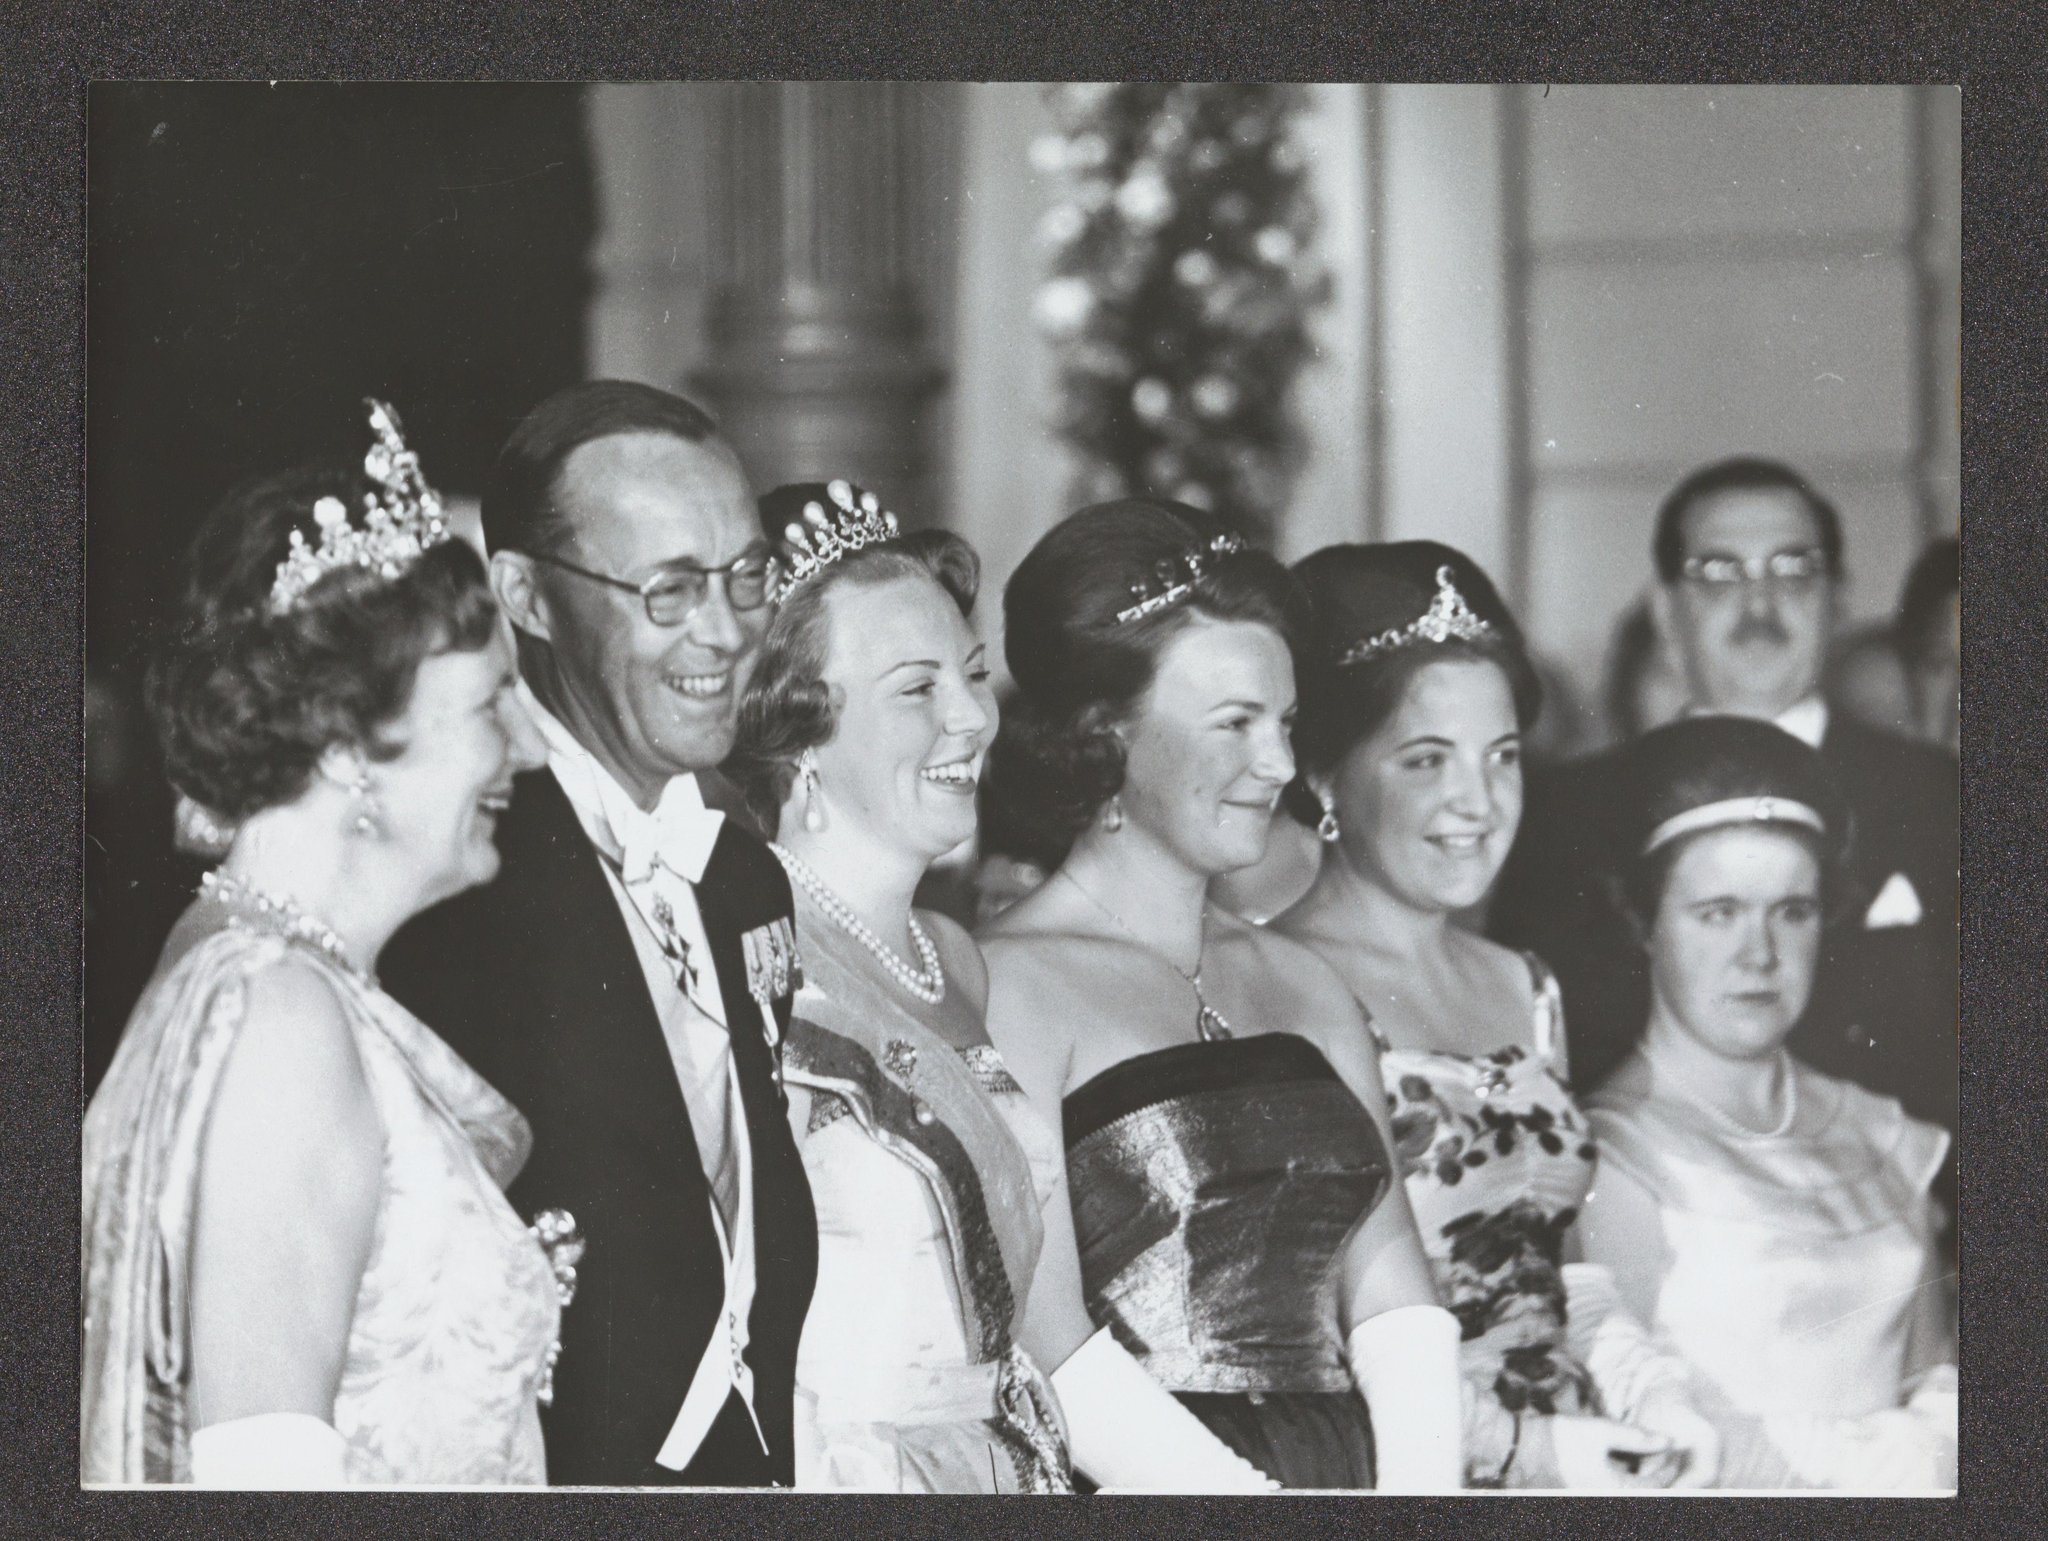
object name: photograph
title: Koningin Juliana, prins Bernhard, prinses Beatrix, prinses Irene, prinses Margriet en prinses Marijke in het Concertgebouw ter gelegenheid van het zilveren huwelijk van de twee eerstgenoemden, Amsterdam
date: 1962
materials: paper, photographic support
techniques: gelatin silver print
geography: netherlands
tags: beatrix (koningin der nederlanden)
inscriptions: annotation: ‘Silver-wedding Queen Juliana and Prince Bernhard. / In the Concertgebouw in Amsterdam the Royal Couple / has been jubilated in the evening of the first day. / Photo: f.l.t.r. Queen Juliana, Prince Bernard, / Princess Beatrix, Princess Irener, Princess / Margriet, Princess Marijke. / FOTO- ANEFO 1-5-1962’